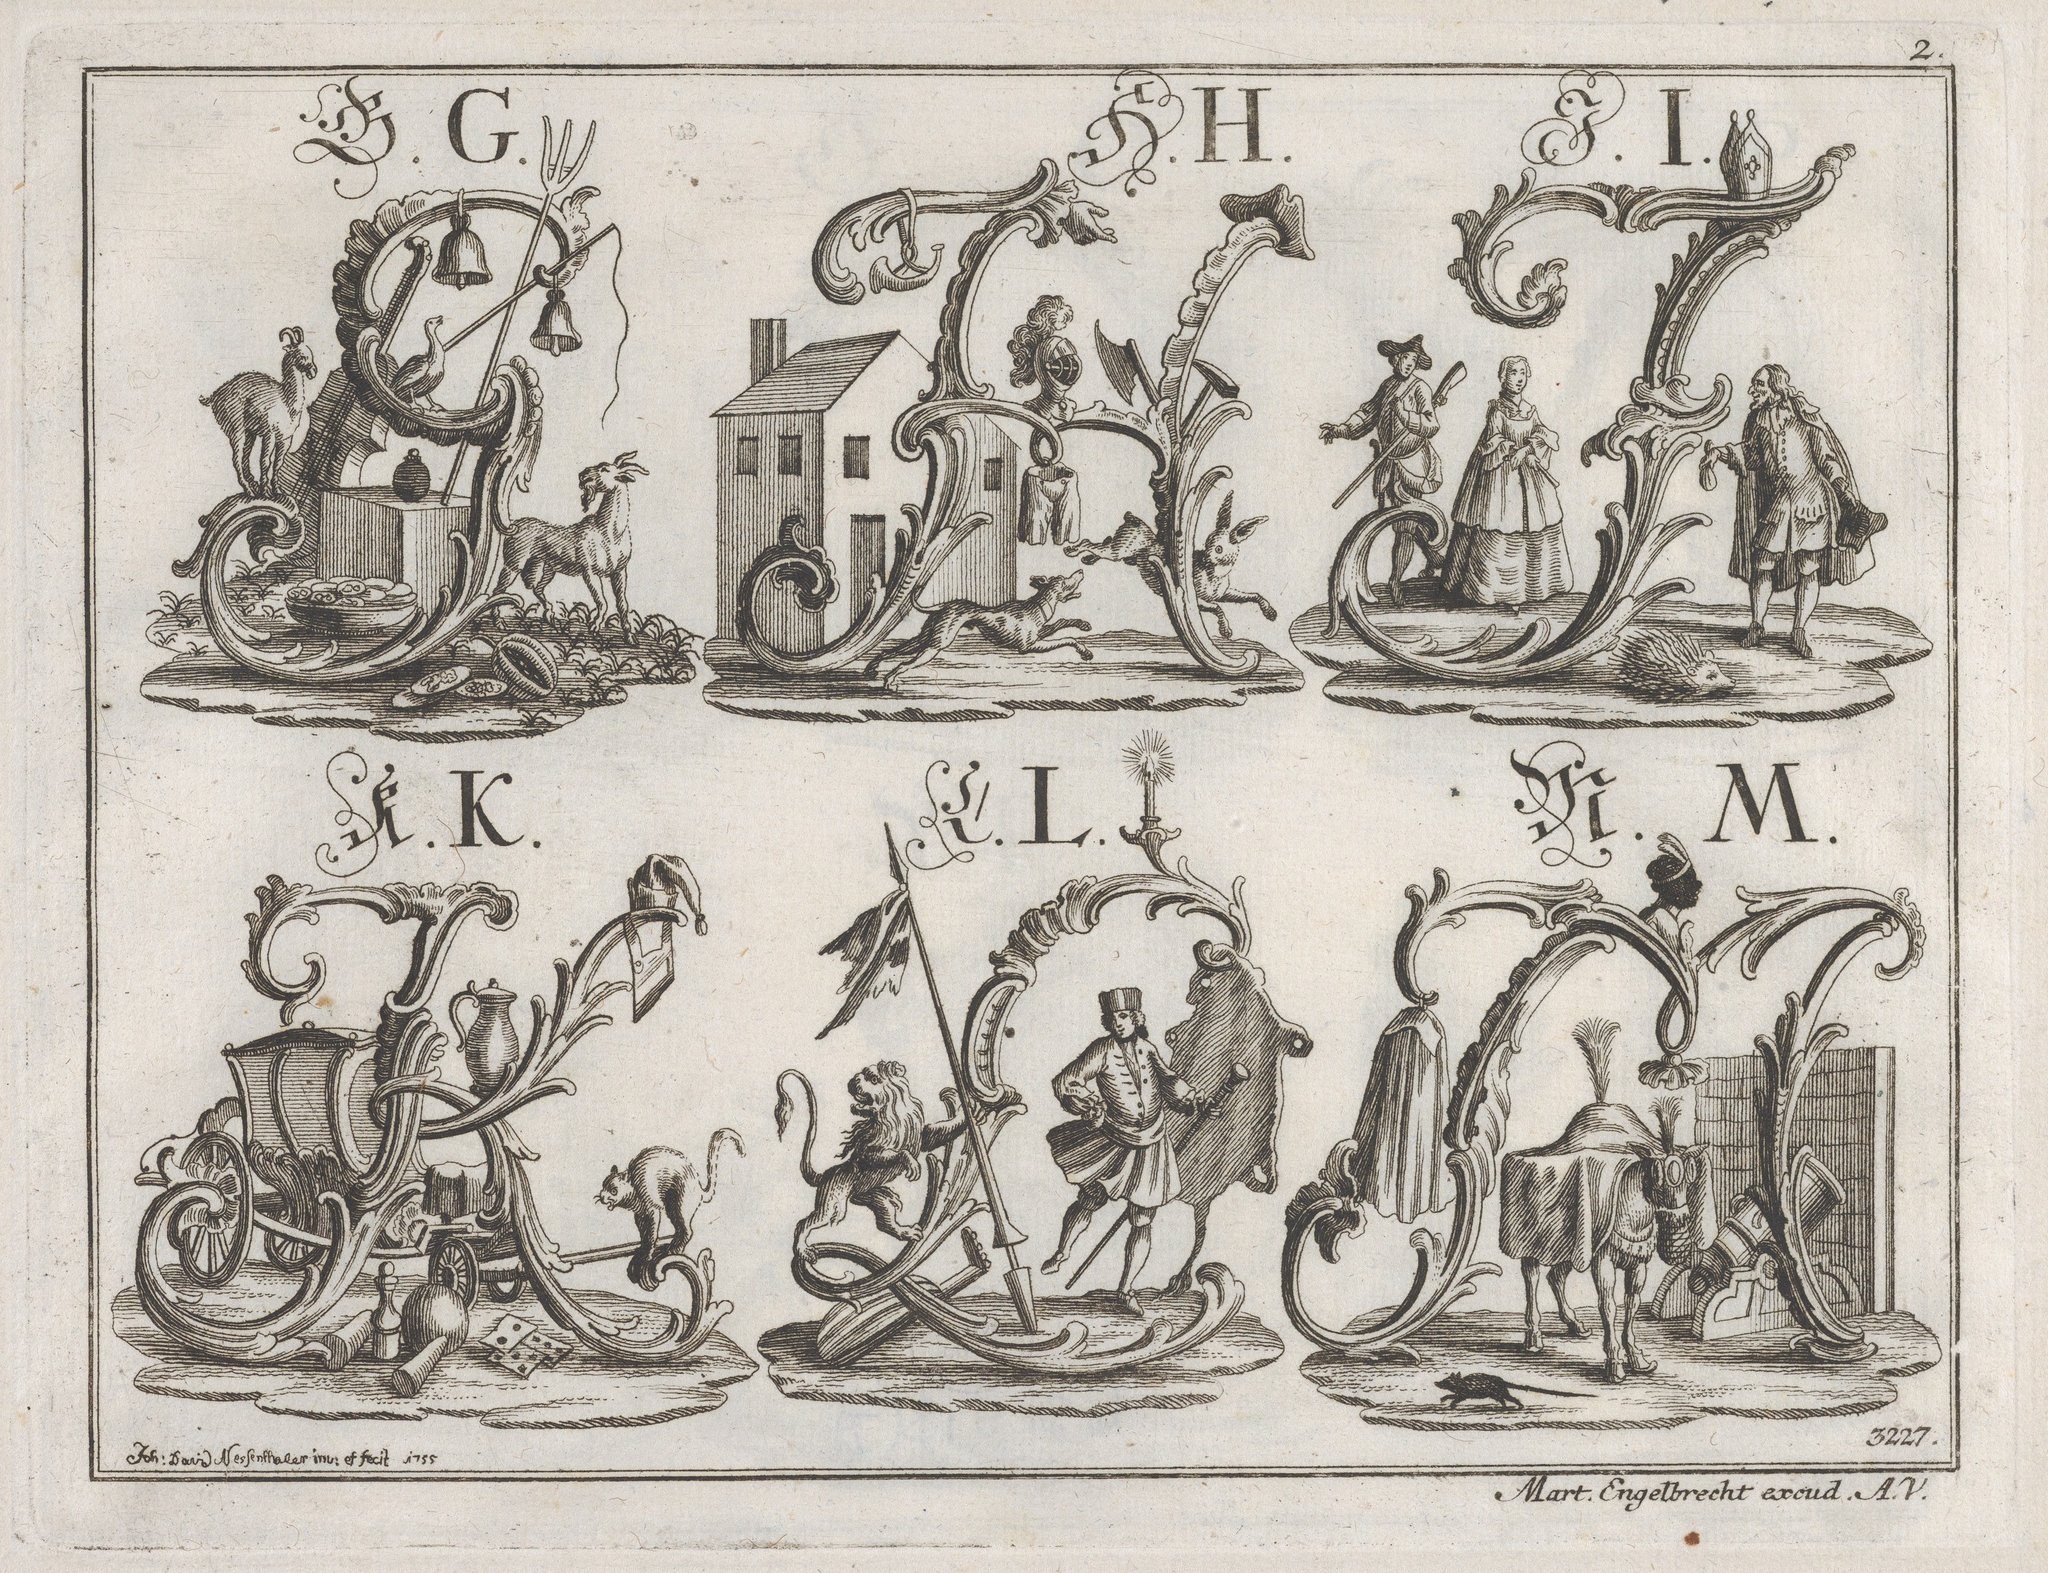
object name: print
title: Decorated Roman alphabet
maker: johann david nessenthaler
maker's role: artist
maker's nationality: german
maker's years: 1712-1766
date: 1755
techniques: engraving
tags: animals,men,women